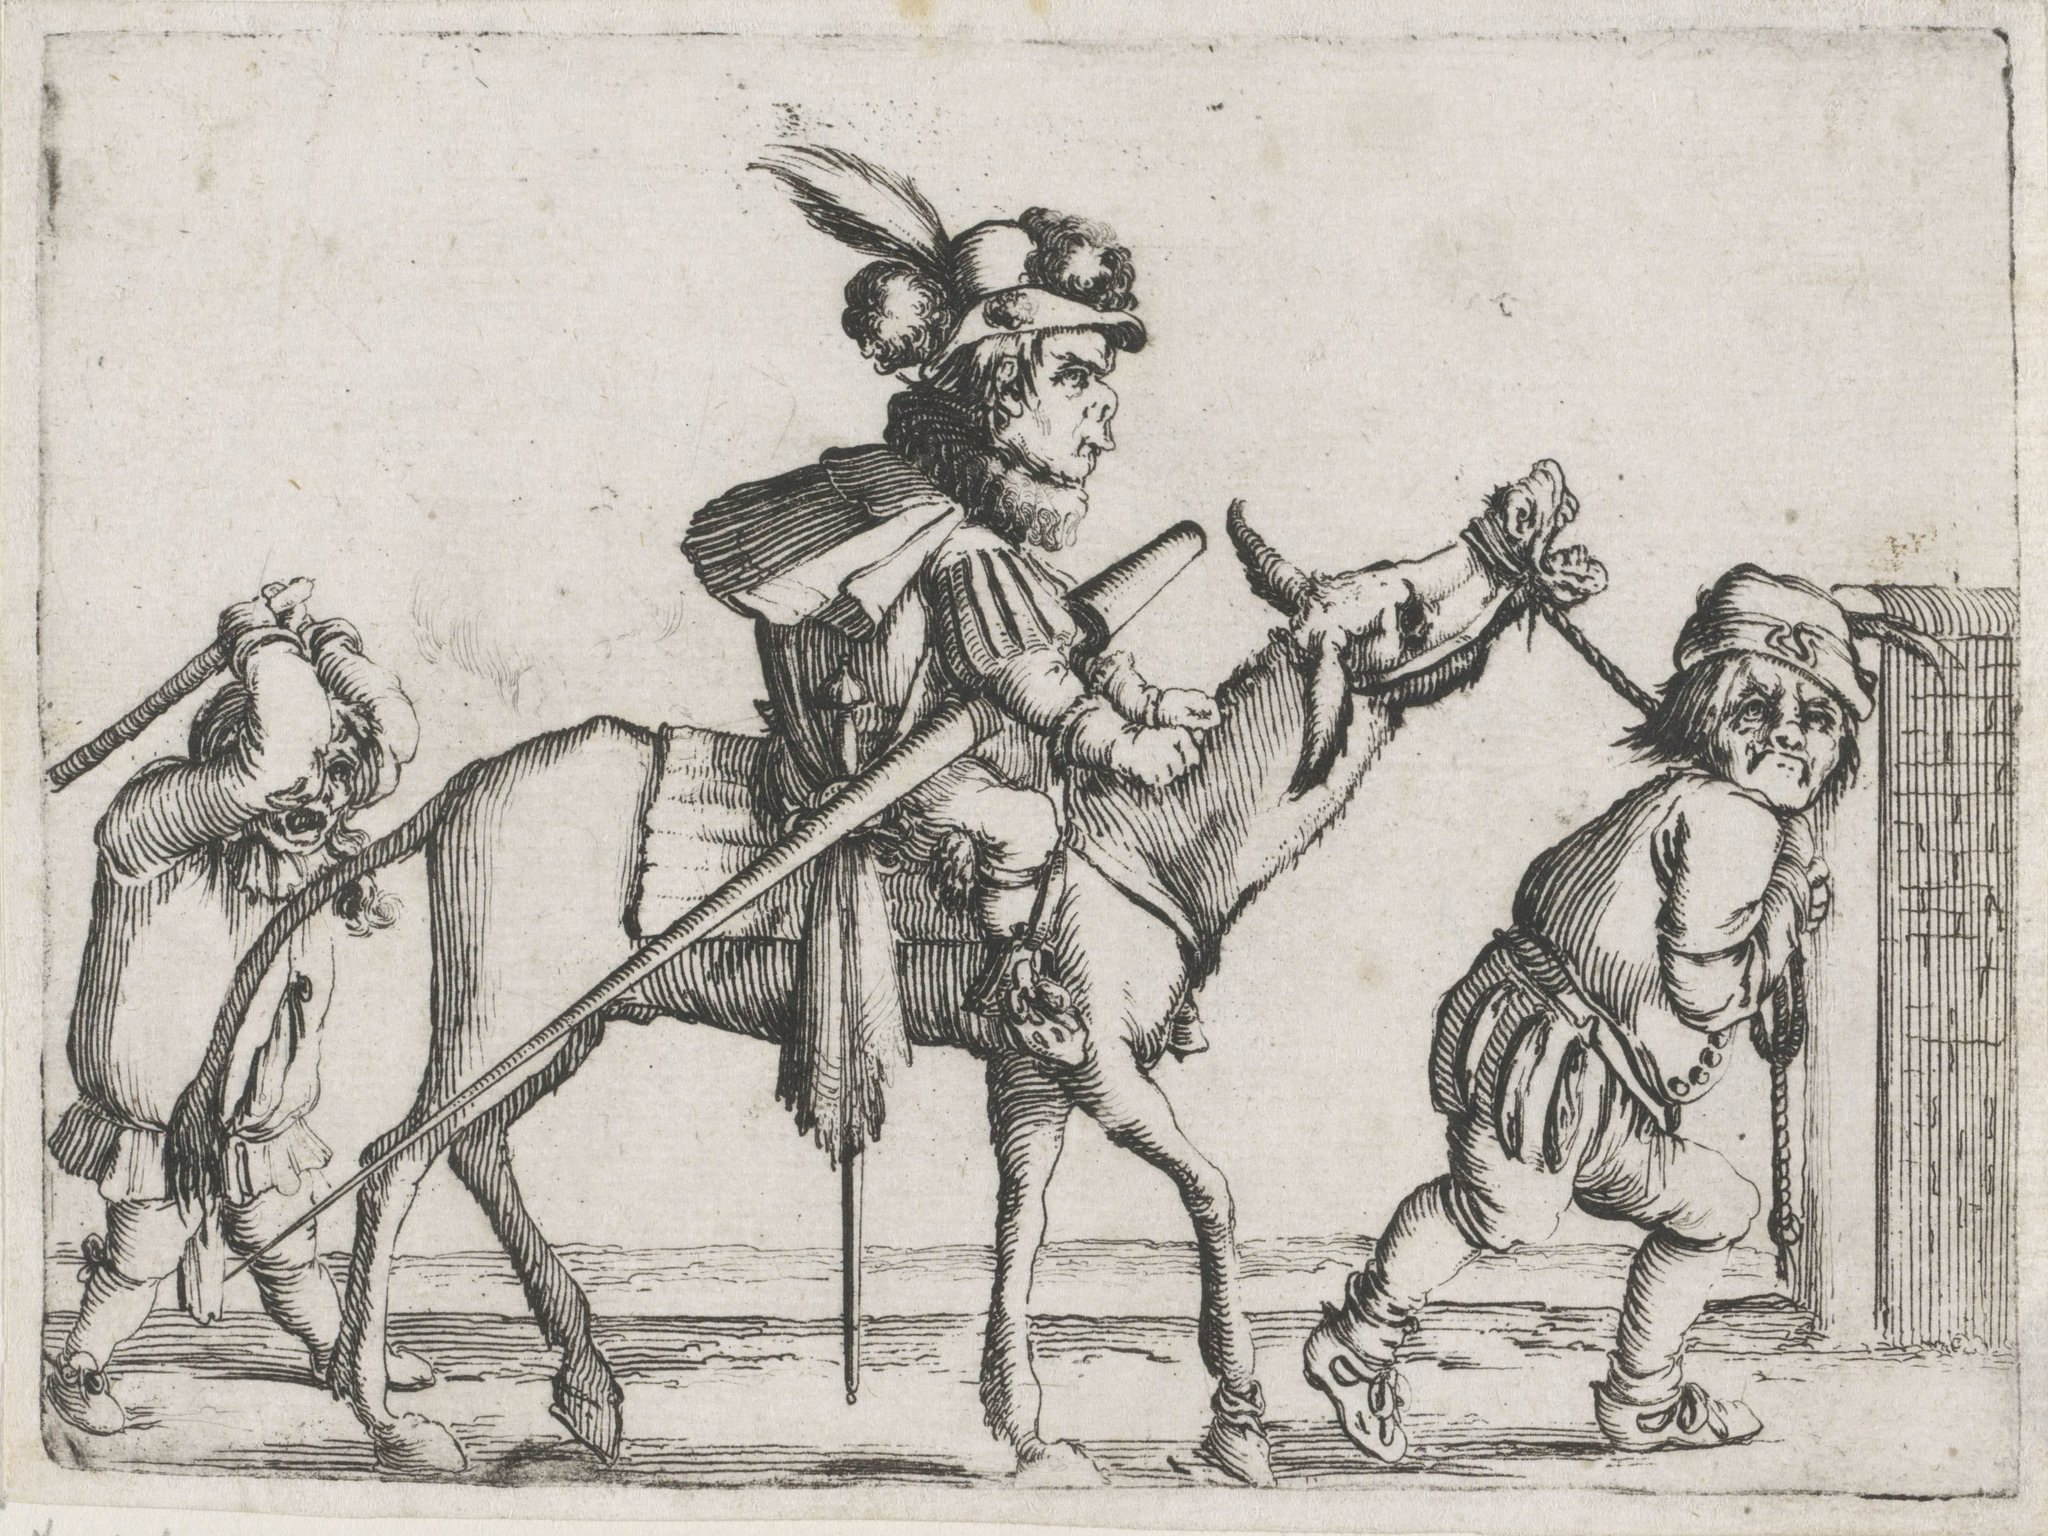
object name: print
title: Dwergen en een ezel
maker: stefano della bella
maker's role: draughtsman, print maker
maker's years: 1610-1664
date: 1620-1664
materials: paper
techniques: etching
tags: ass, donkey, little people, man tormenting animal(s)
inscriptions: collector's mark: Lugt 240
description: Een kleine mens (karikatuur) slaat een ezel, een tweede kleine mens (karikatuur) zit op de ezel en een derde kleine mens (karikatuur) trekt de ezel vooruit.